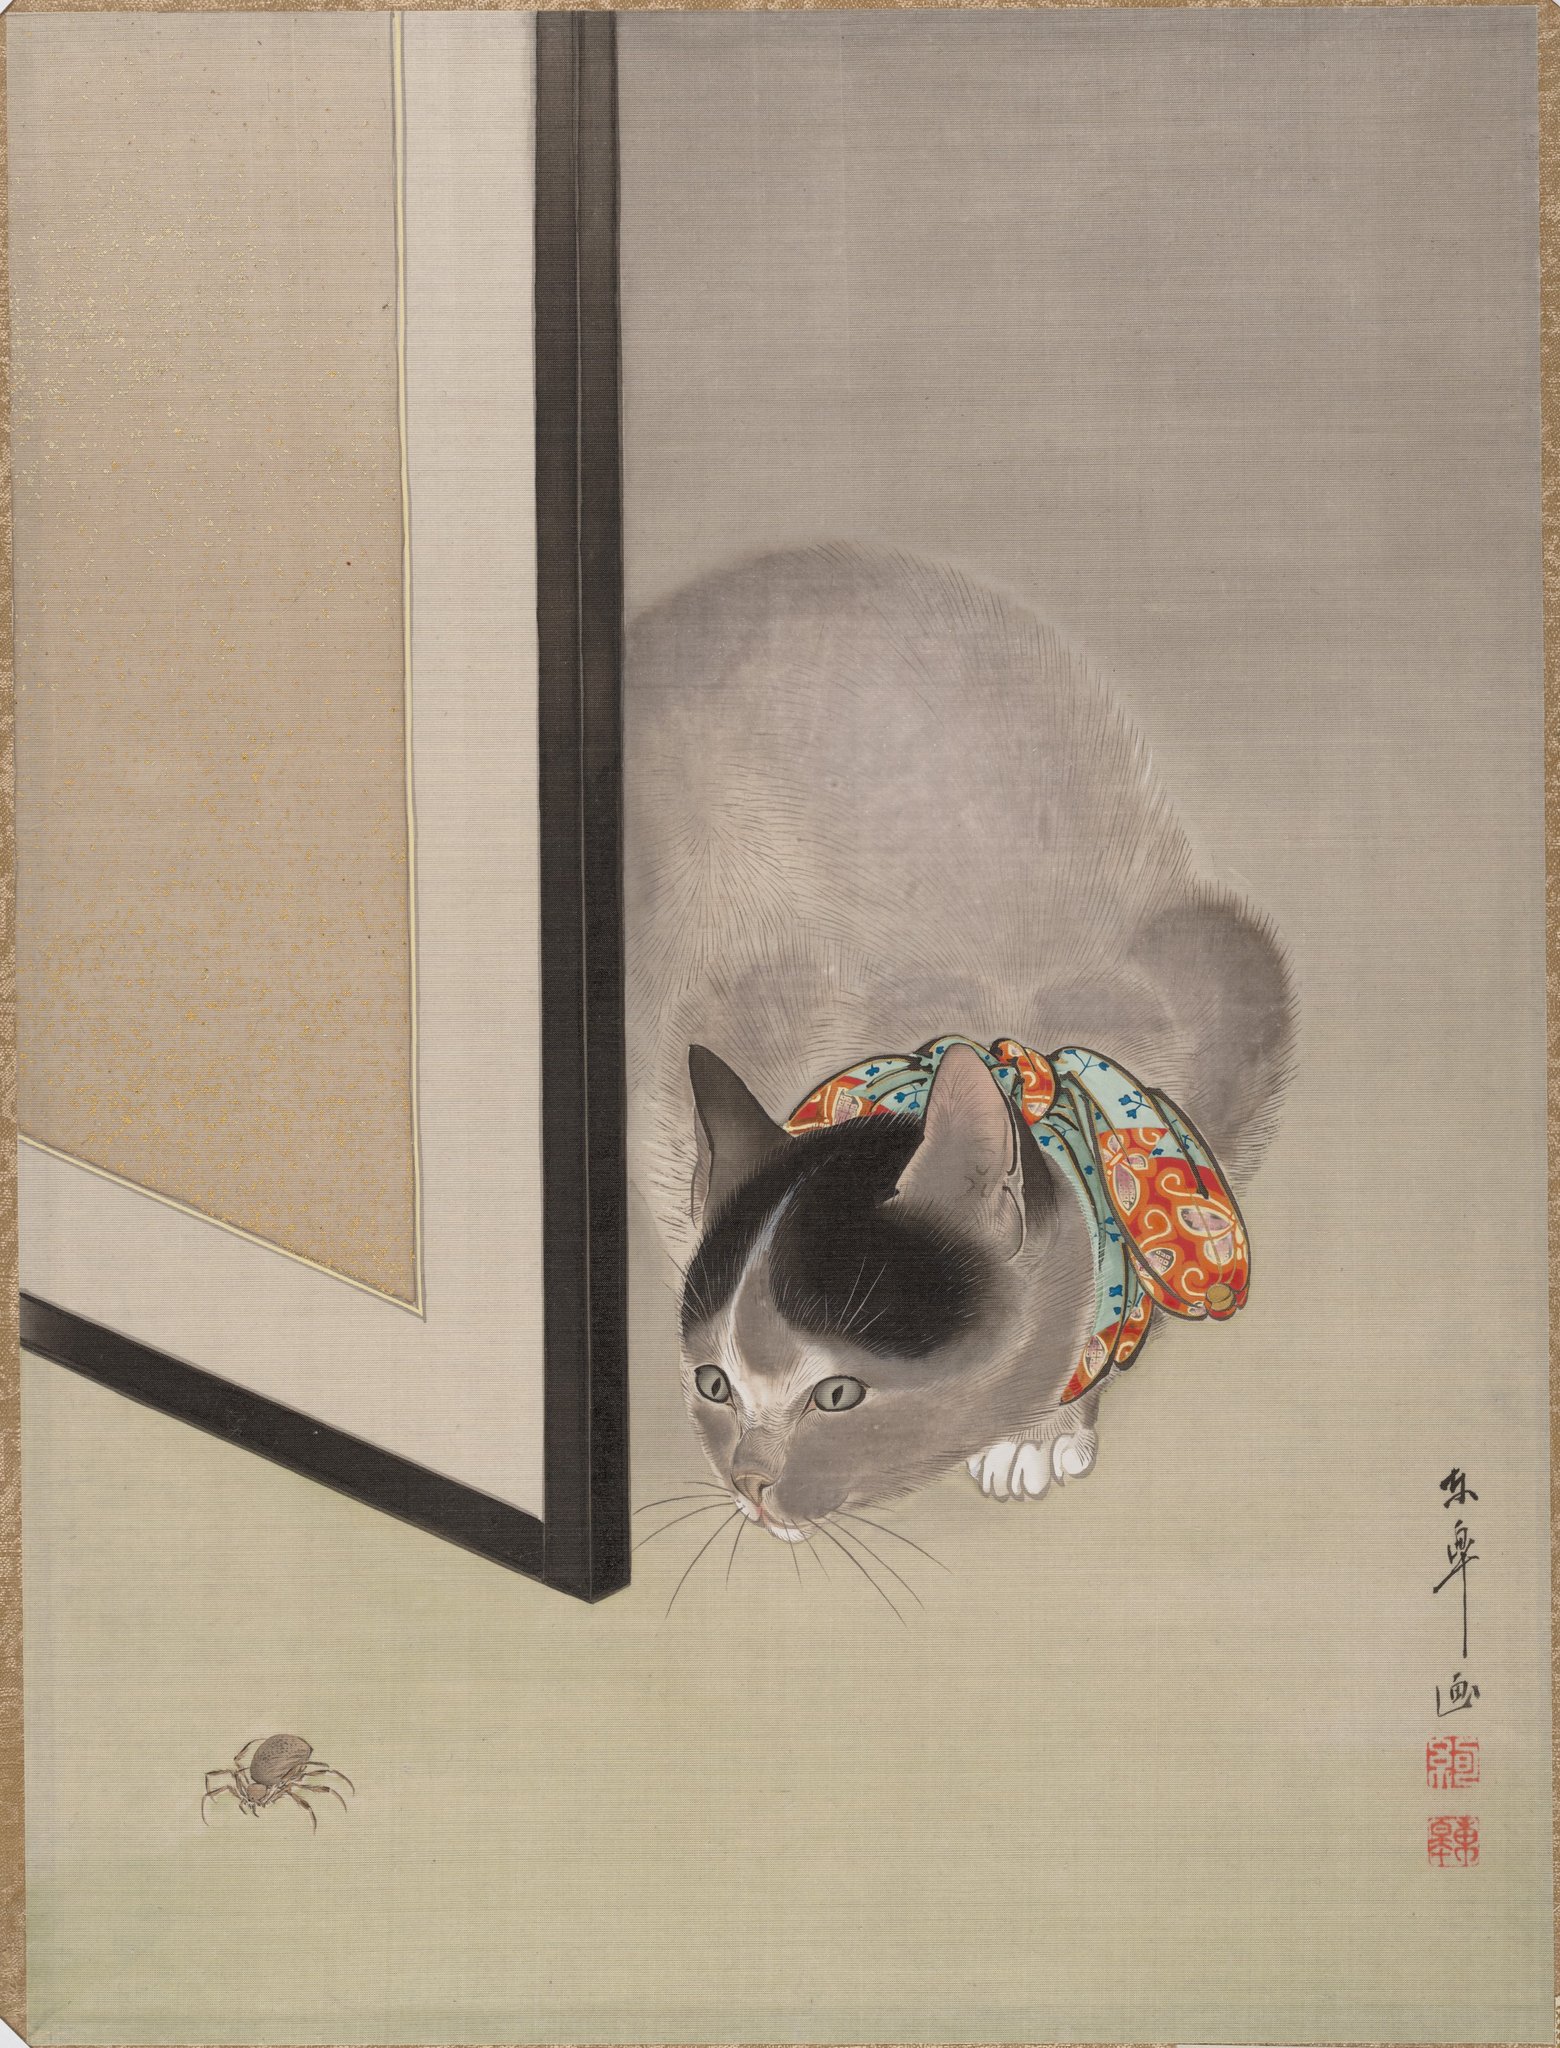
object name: album leaf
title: Cat Watching a Spider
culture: japanese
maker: oide tōkō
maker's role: artist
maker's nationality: japanese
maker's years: 1841-1905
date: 1888-1892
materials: ink, silk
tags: cats,spiders